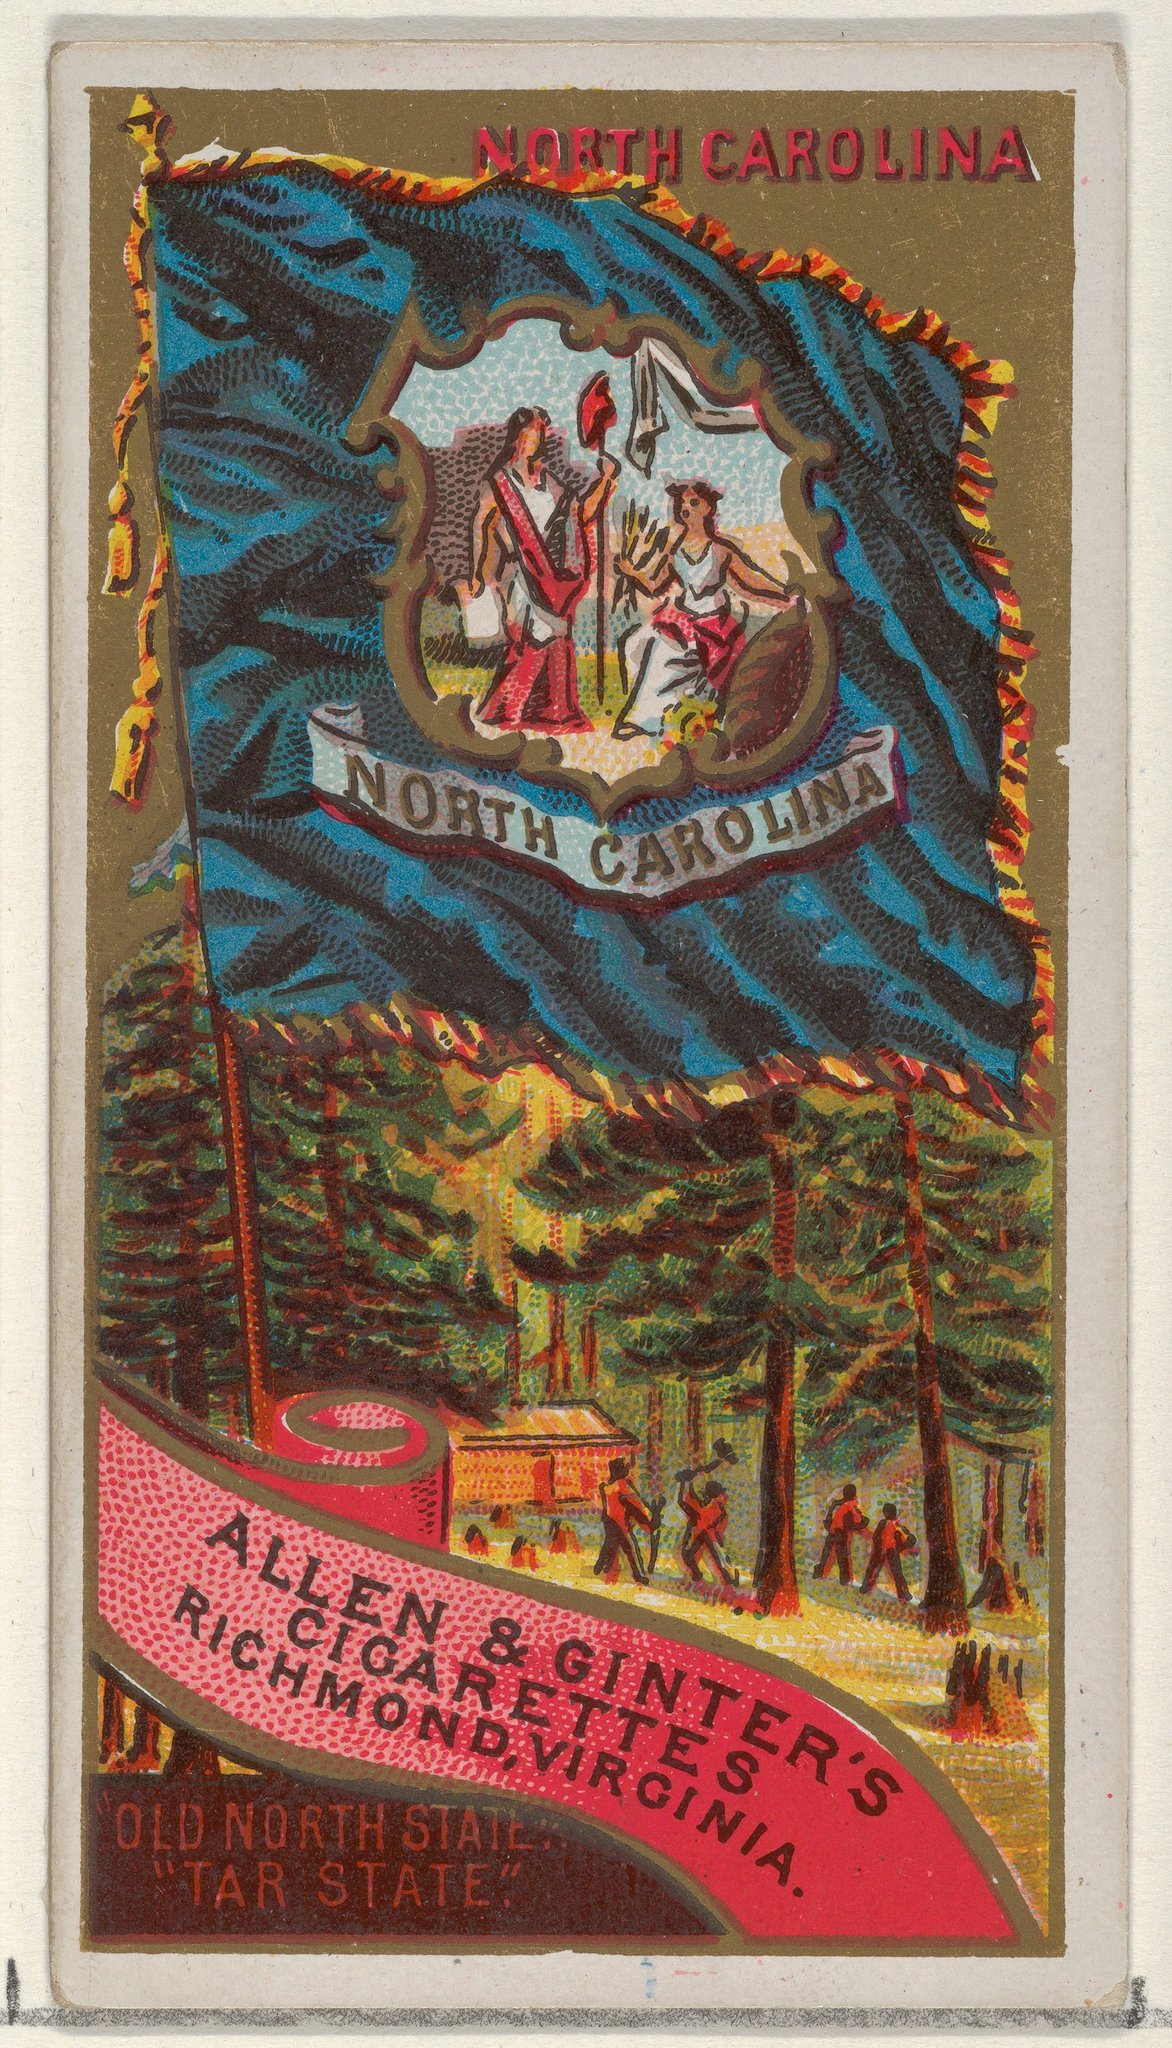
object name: print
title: North Carolina, from Flags of the States and Territories (N11) for Allen & Ginter Cigarettes Brands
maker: allen & ginter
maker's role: publisher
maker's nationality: american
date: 1888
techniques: color lithograph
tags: flags